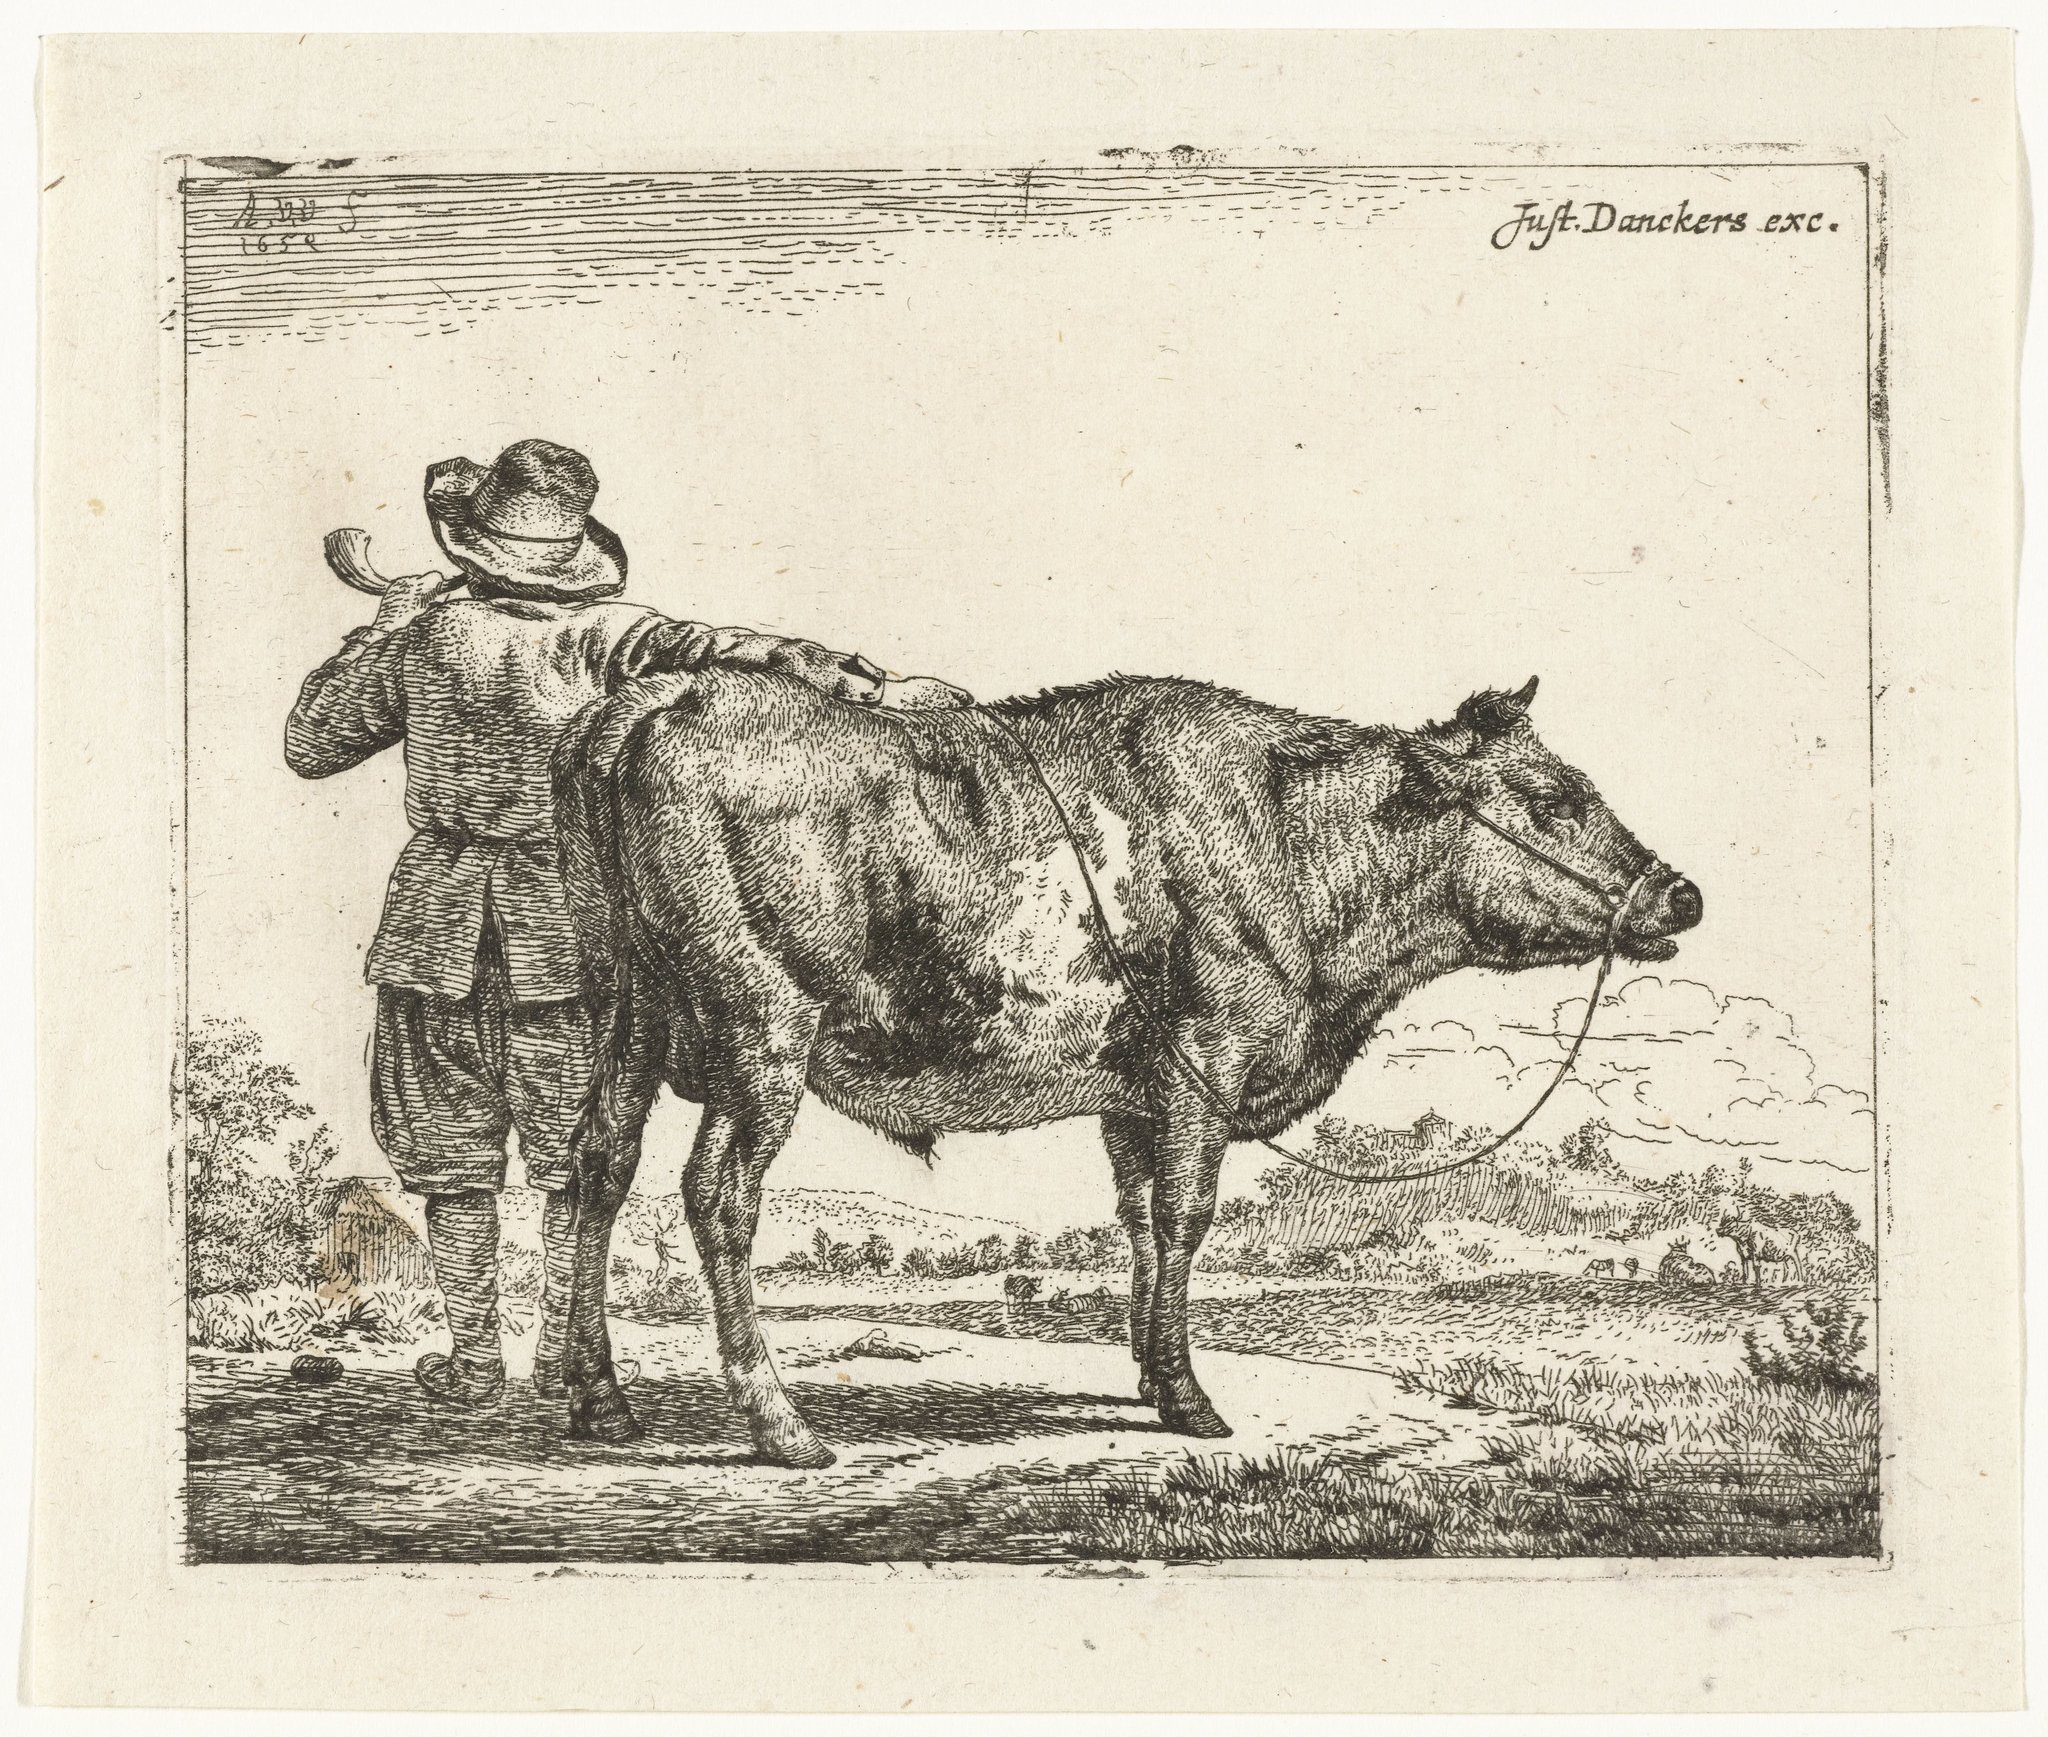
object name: print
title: Jonge herder met een stier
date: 1659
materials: paper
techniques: etching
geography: amsterdam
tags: bull, herding, herdsman, herdswoman, shepherd, shepherdess, cowherd, etc.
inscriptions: collector's mark: Lugt 240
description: Eerste prent uit een serie van tien prenten met verschillende dieren. Van de Velde nam het thema met de jonge herder en de stier over van een vroeg schilderij van Jacob Isaacksz. van Ruisdael uit 1646. In het landschap met een boerderij van Ruisdael zijn de herder en de stier met de opvallende witte vlek op de flank klein in de compositie geplaatst. Van de Velde maakte het groepje los uit de oorspronkelijke context en volgde bij zijn weergave nauwkeurig ieder detail. De herder die op zijn hoorn blaast terwijl hij de stier aan een touw vasthoudt staan groot op de voorgrond in een licht glooiend landschap.